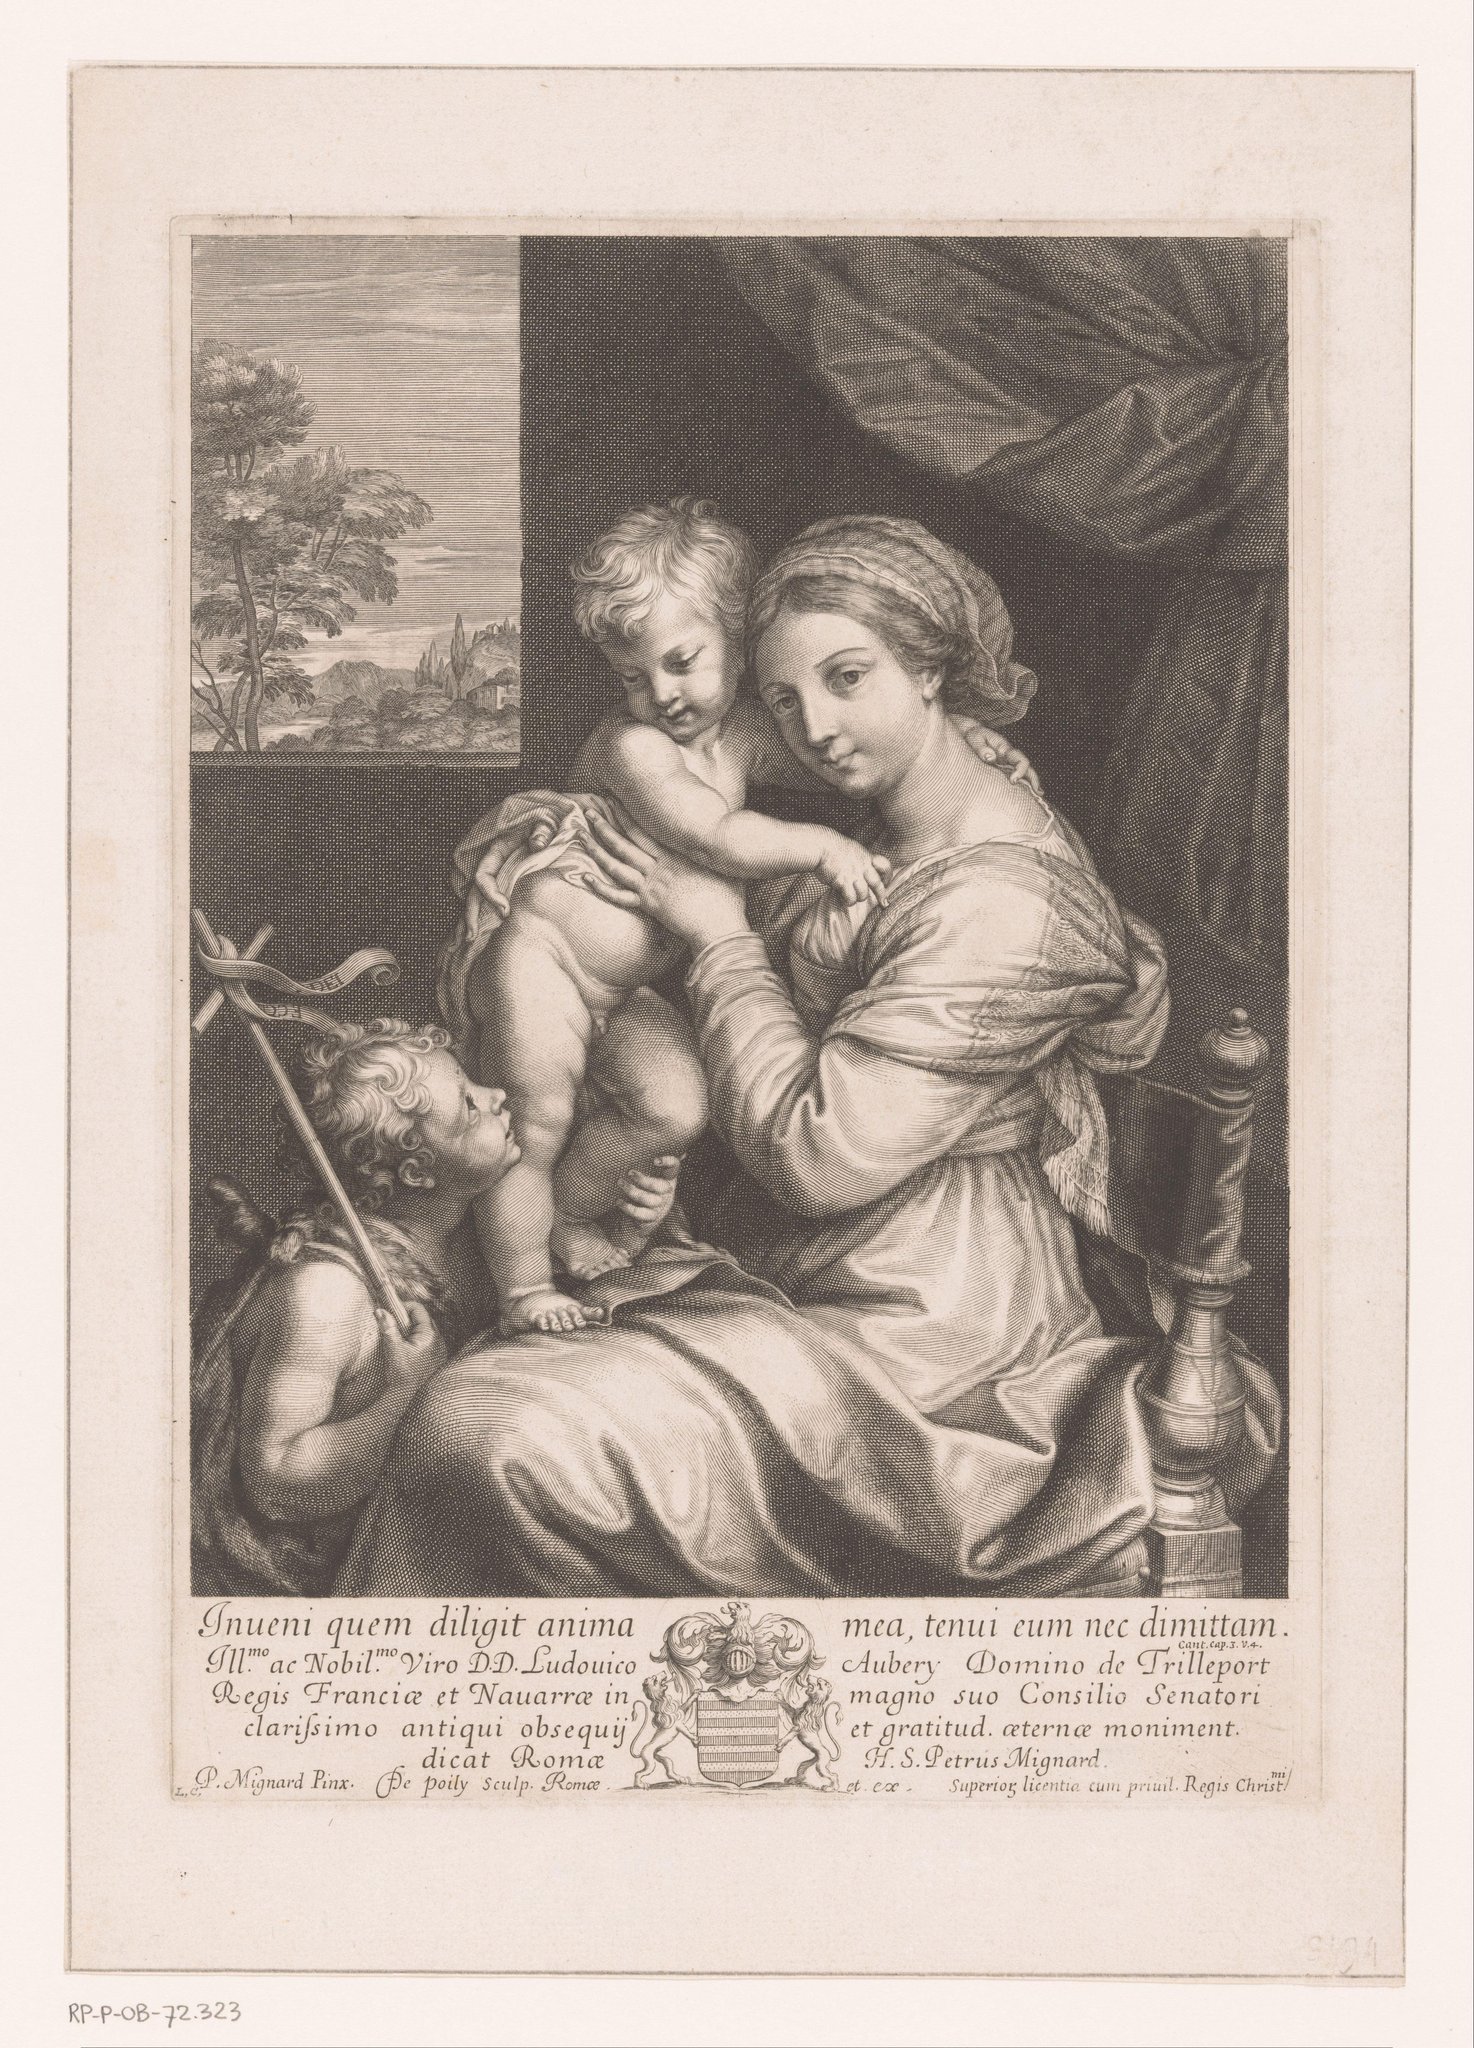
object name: print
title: Maria met kind staand op haar schoot en Johannes de Doper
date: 1632-1693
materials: paper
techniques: engraving, etching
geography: rome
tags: madonna: mary sitting or enthroned, the christ-child in her lap (or in front of her bosom) (mary sometimes represented half-length), john the baptist as child ~ madonna-representations (n.b. secondary notation only)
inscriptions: collector's mark: Lugt 2228